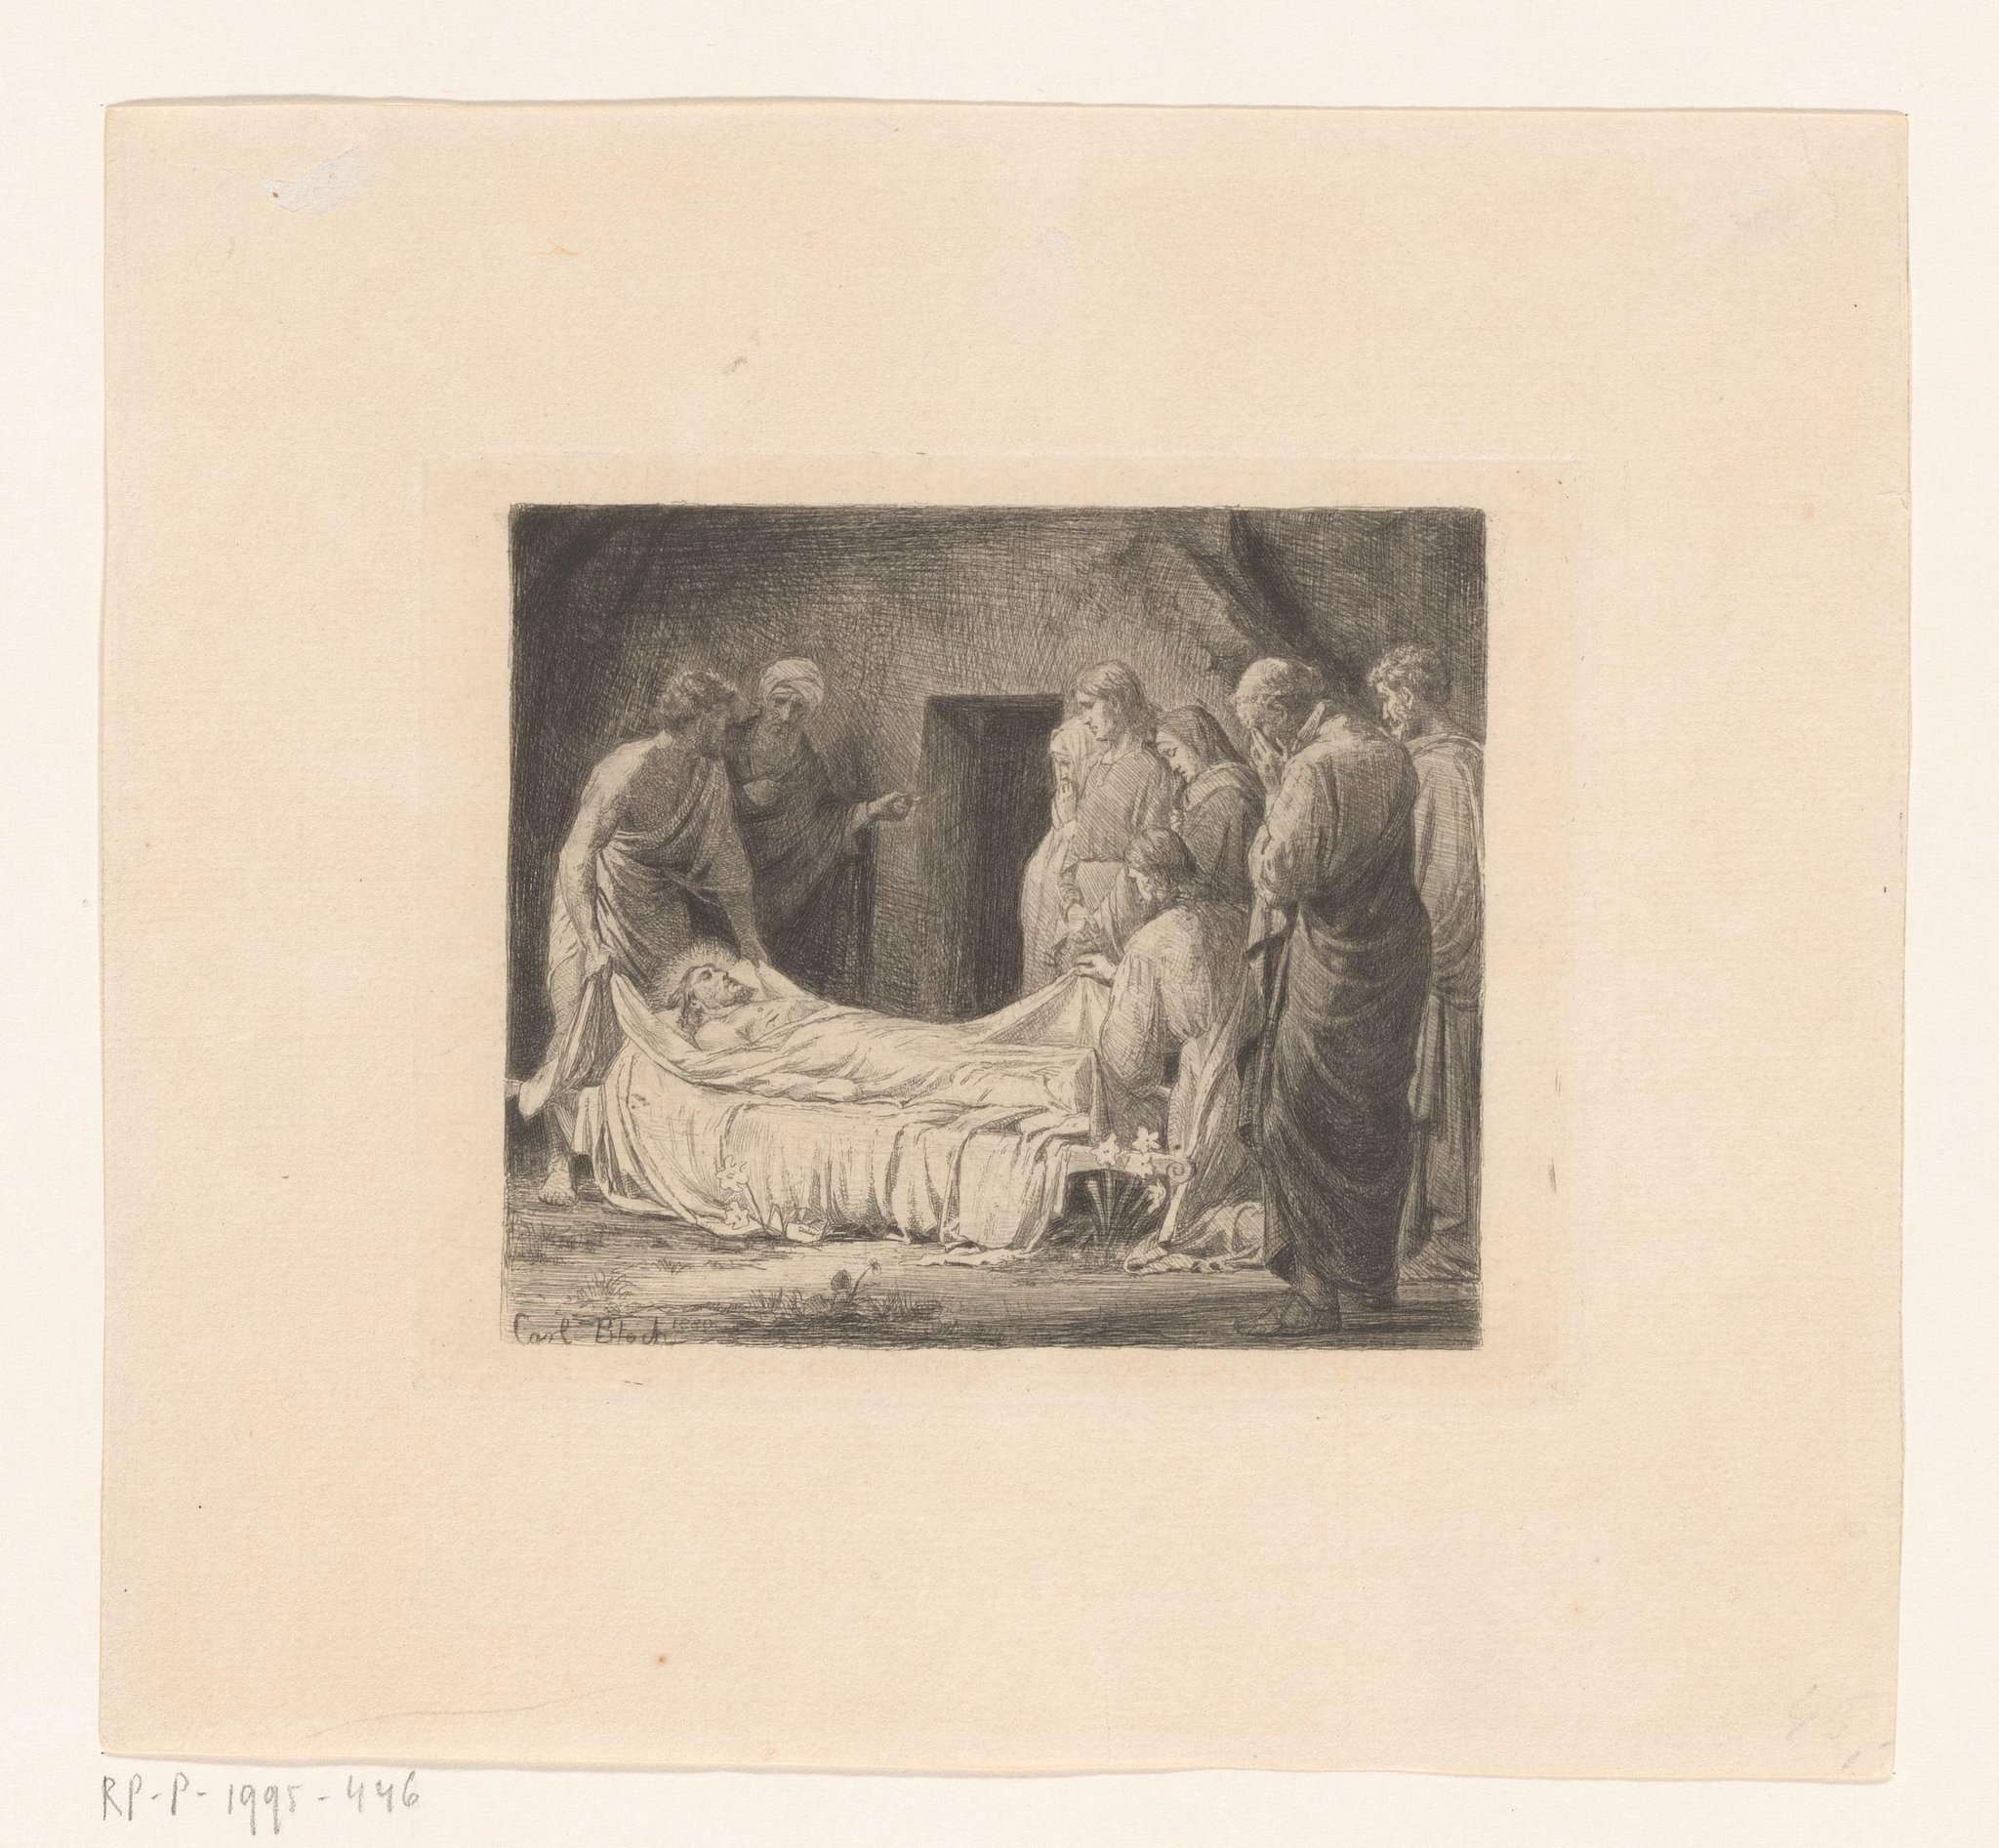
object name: print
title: De graflegging van Christus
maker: carl bloch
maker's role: print maker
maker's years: 1834-1890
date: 1880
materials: paper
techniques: drypoint, etching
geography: scandinavia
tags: christ's entombment (possibly by angels)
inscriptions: collector's mark: Lugt 2228, signature and date: ‘l.o. gesigneerd en gedateerd Carl Bloch 1880’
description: De graflegging van Christus, met acht omstanders.